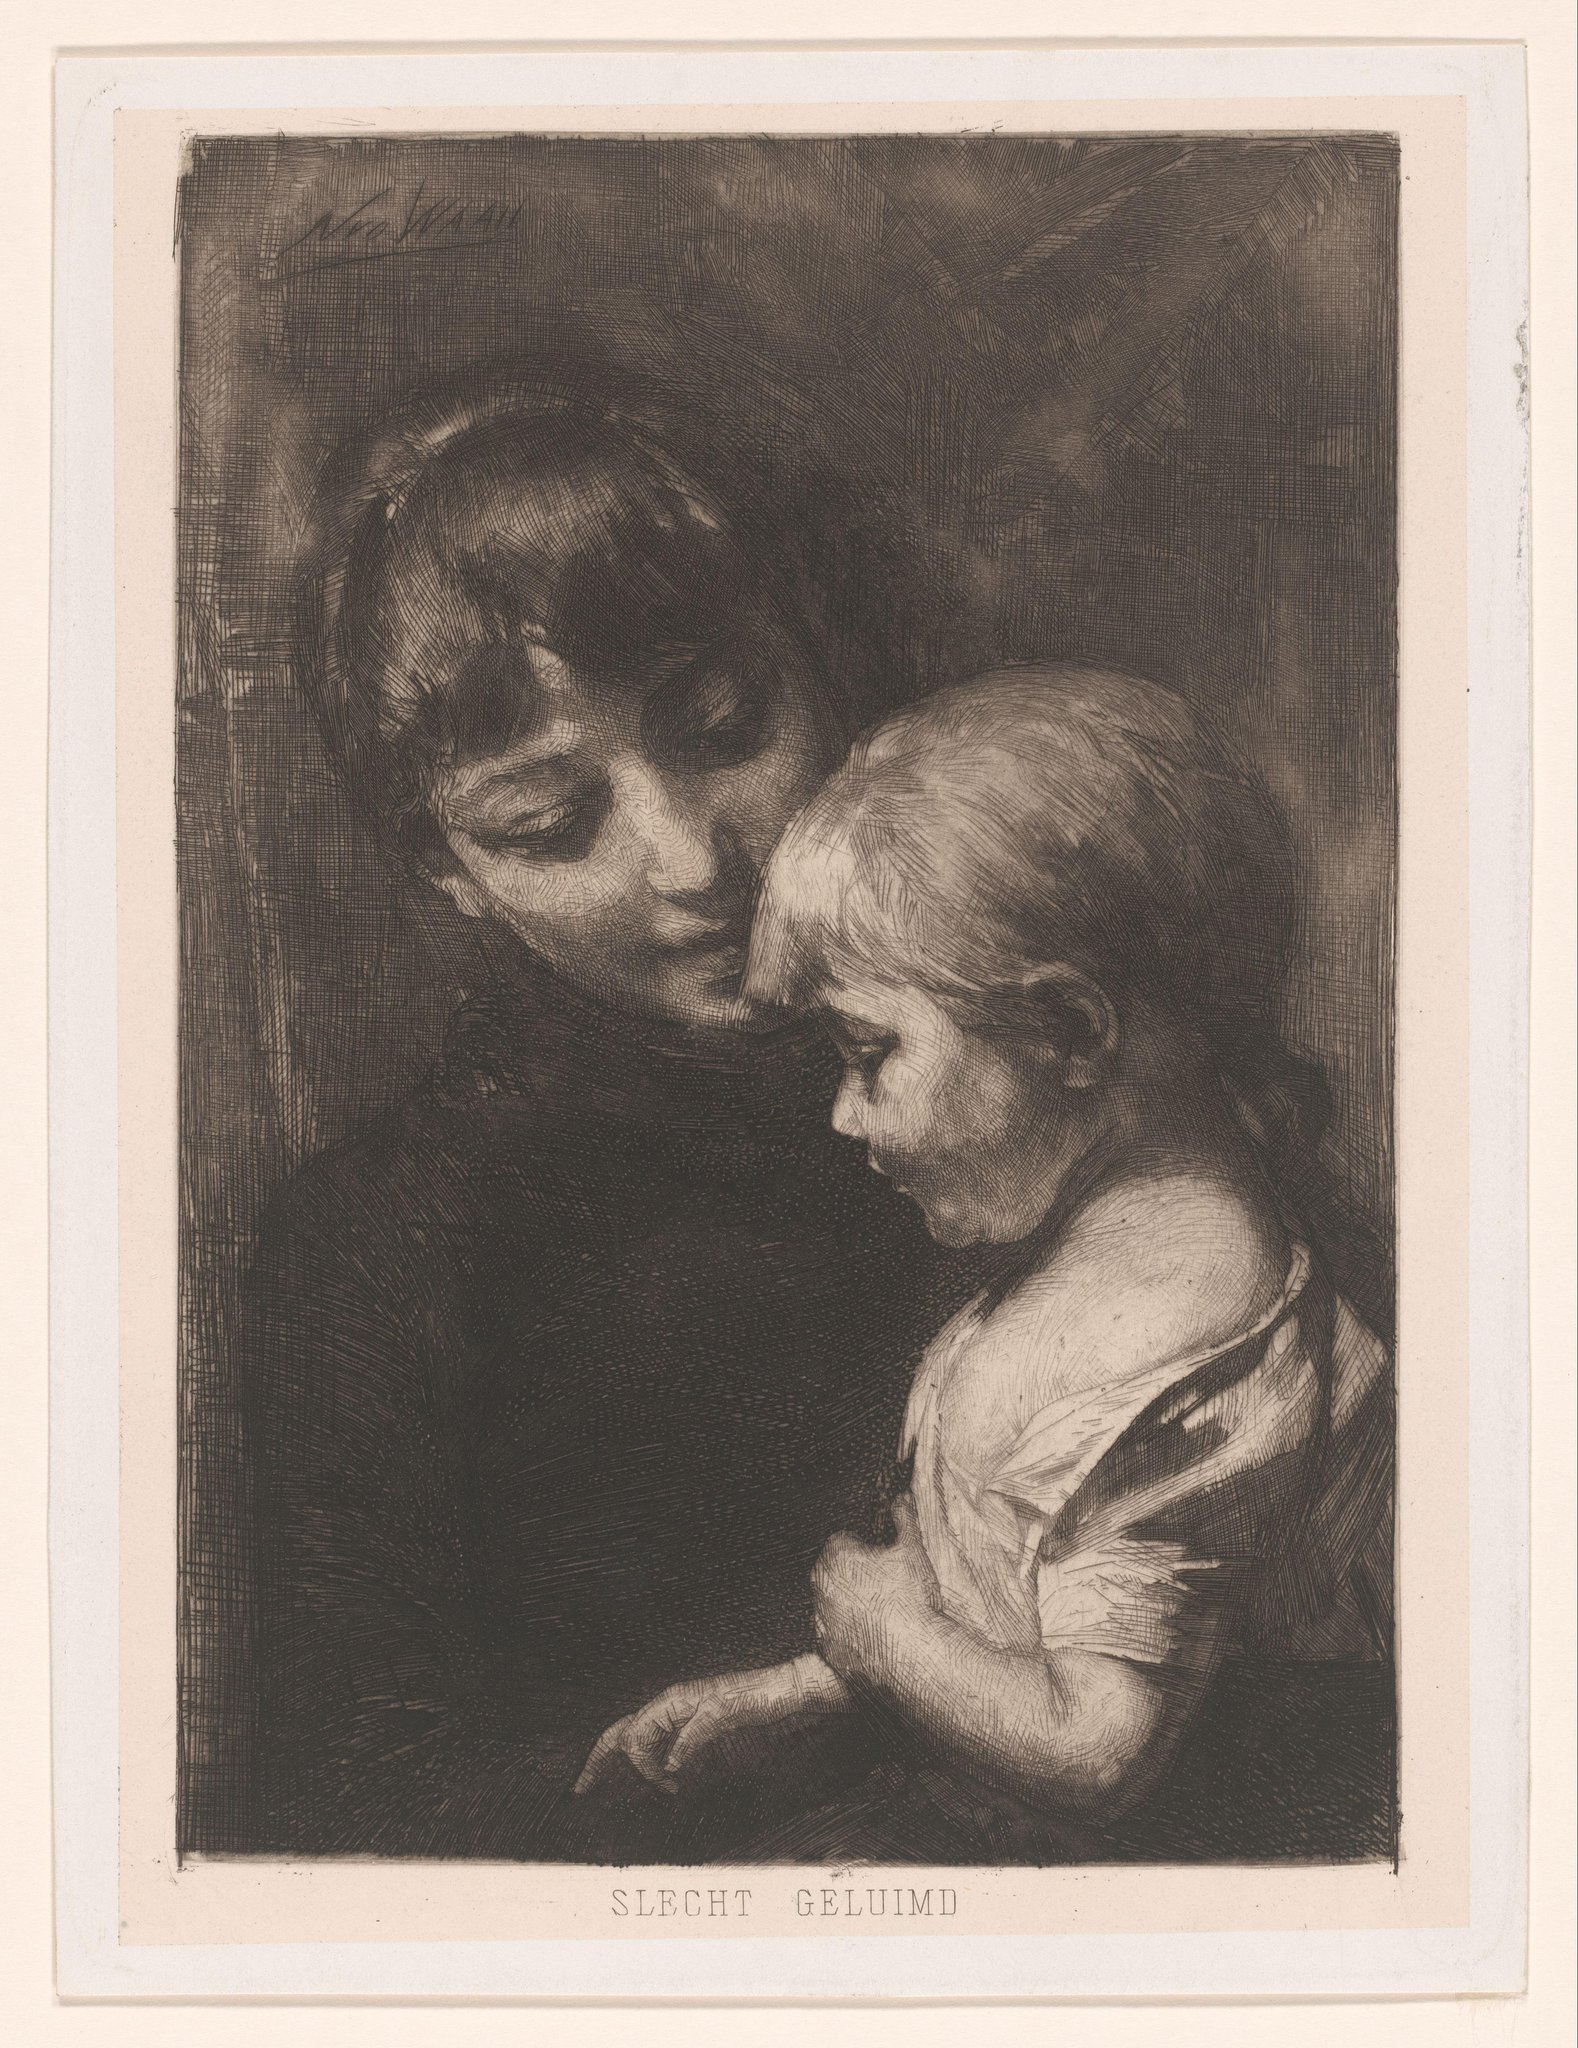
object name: print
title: Slecht geluimd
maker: nicolaas van der waay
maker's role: draughtsman, painter, print maker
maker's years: 1855-1936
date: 1865-1936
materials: paper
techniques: drypoint, etching, intaglio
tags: mother and child(ren), woman and child(ren) (family group)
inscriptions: collector's mark: Lugt 2228